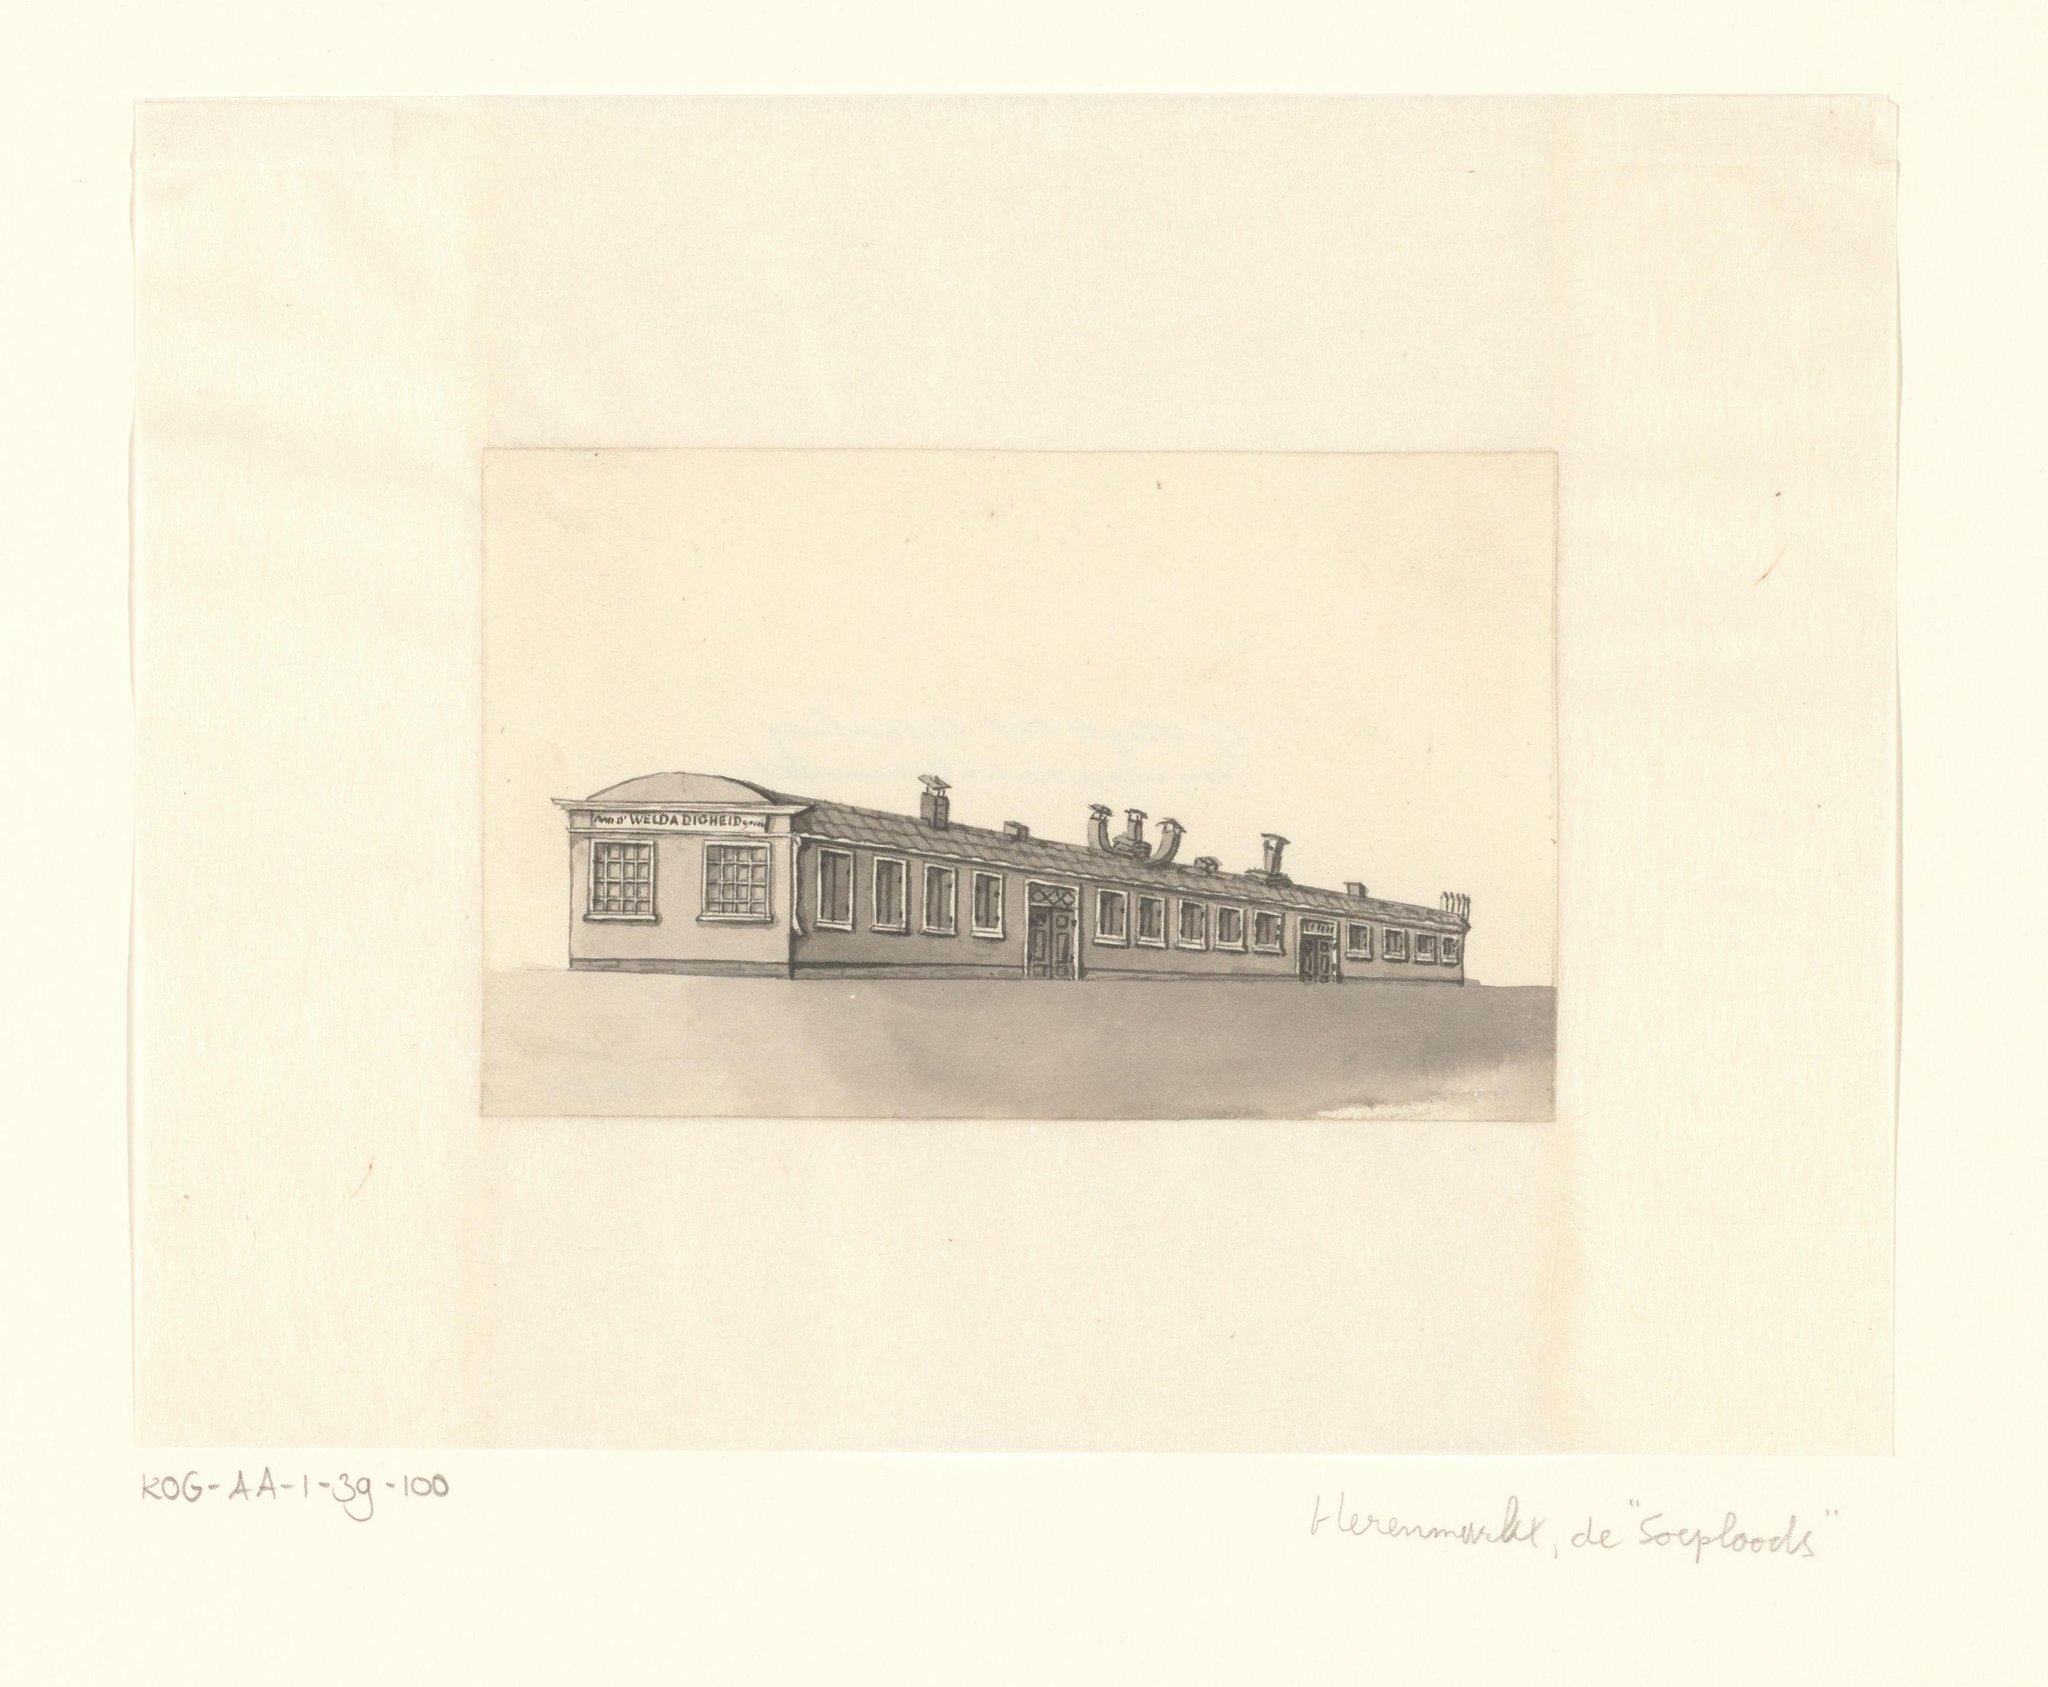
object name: drawing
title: Gezicht op de Soeploods op de Herenmarkt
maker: gerrit postma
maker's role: draughtsman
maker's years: 1819-1894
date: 1829-1894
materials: ink, paper, pencil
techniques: brush, pen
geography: amsterdam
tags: city-view in general; 'veduta', shed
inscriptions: inscription: ‘Gestigt tot uitdeeling / van Soup, op de Heerenmarkt’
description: Onderwerpsrubriek binnen de Atlas Amsterdam: Maatschappij van Weldadigheid - Soeploods op Heerengracht.